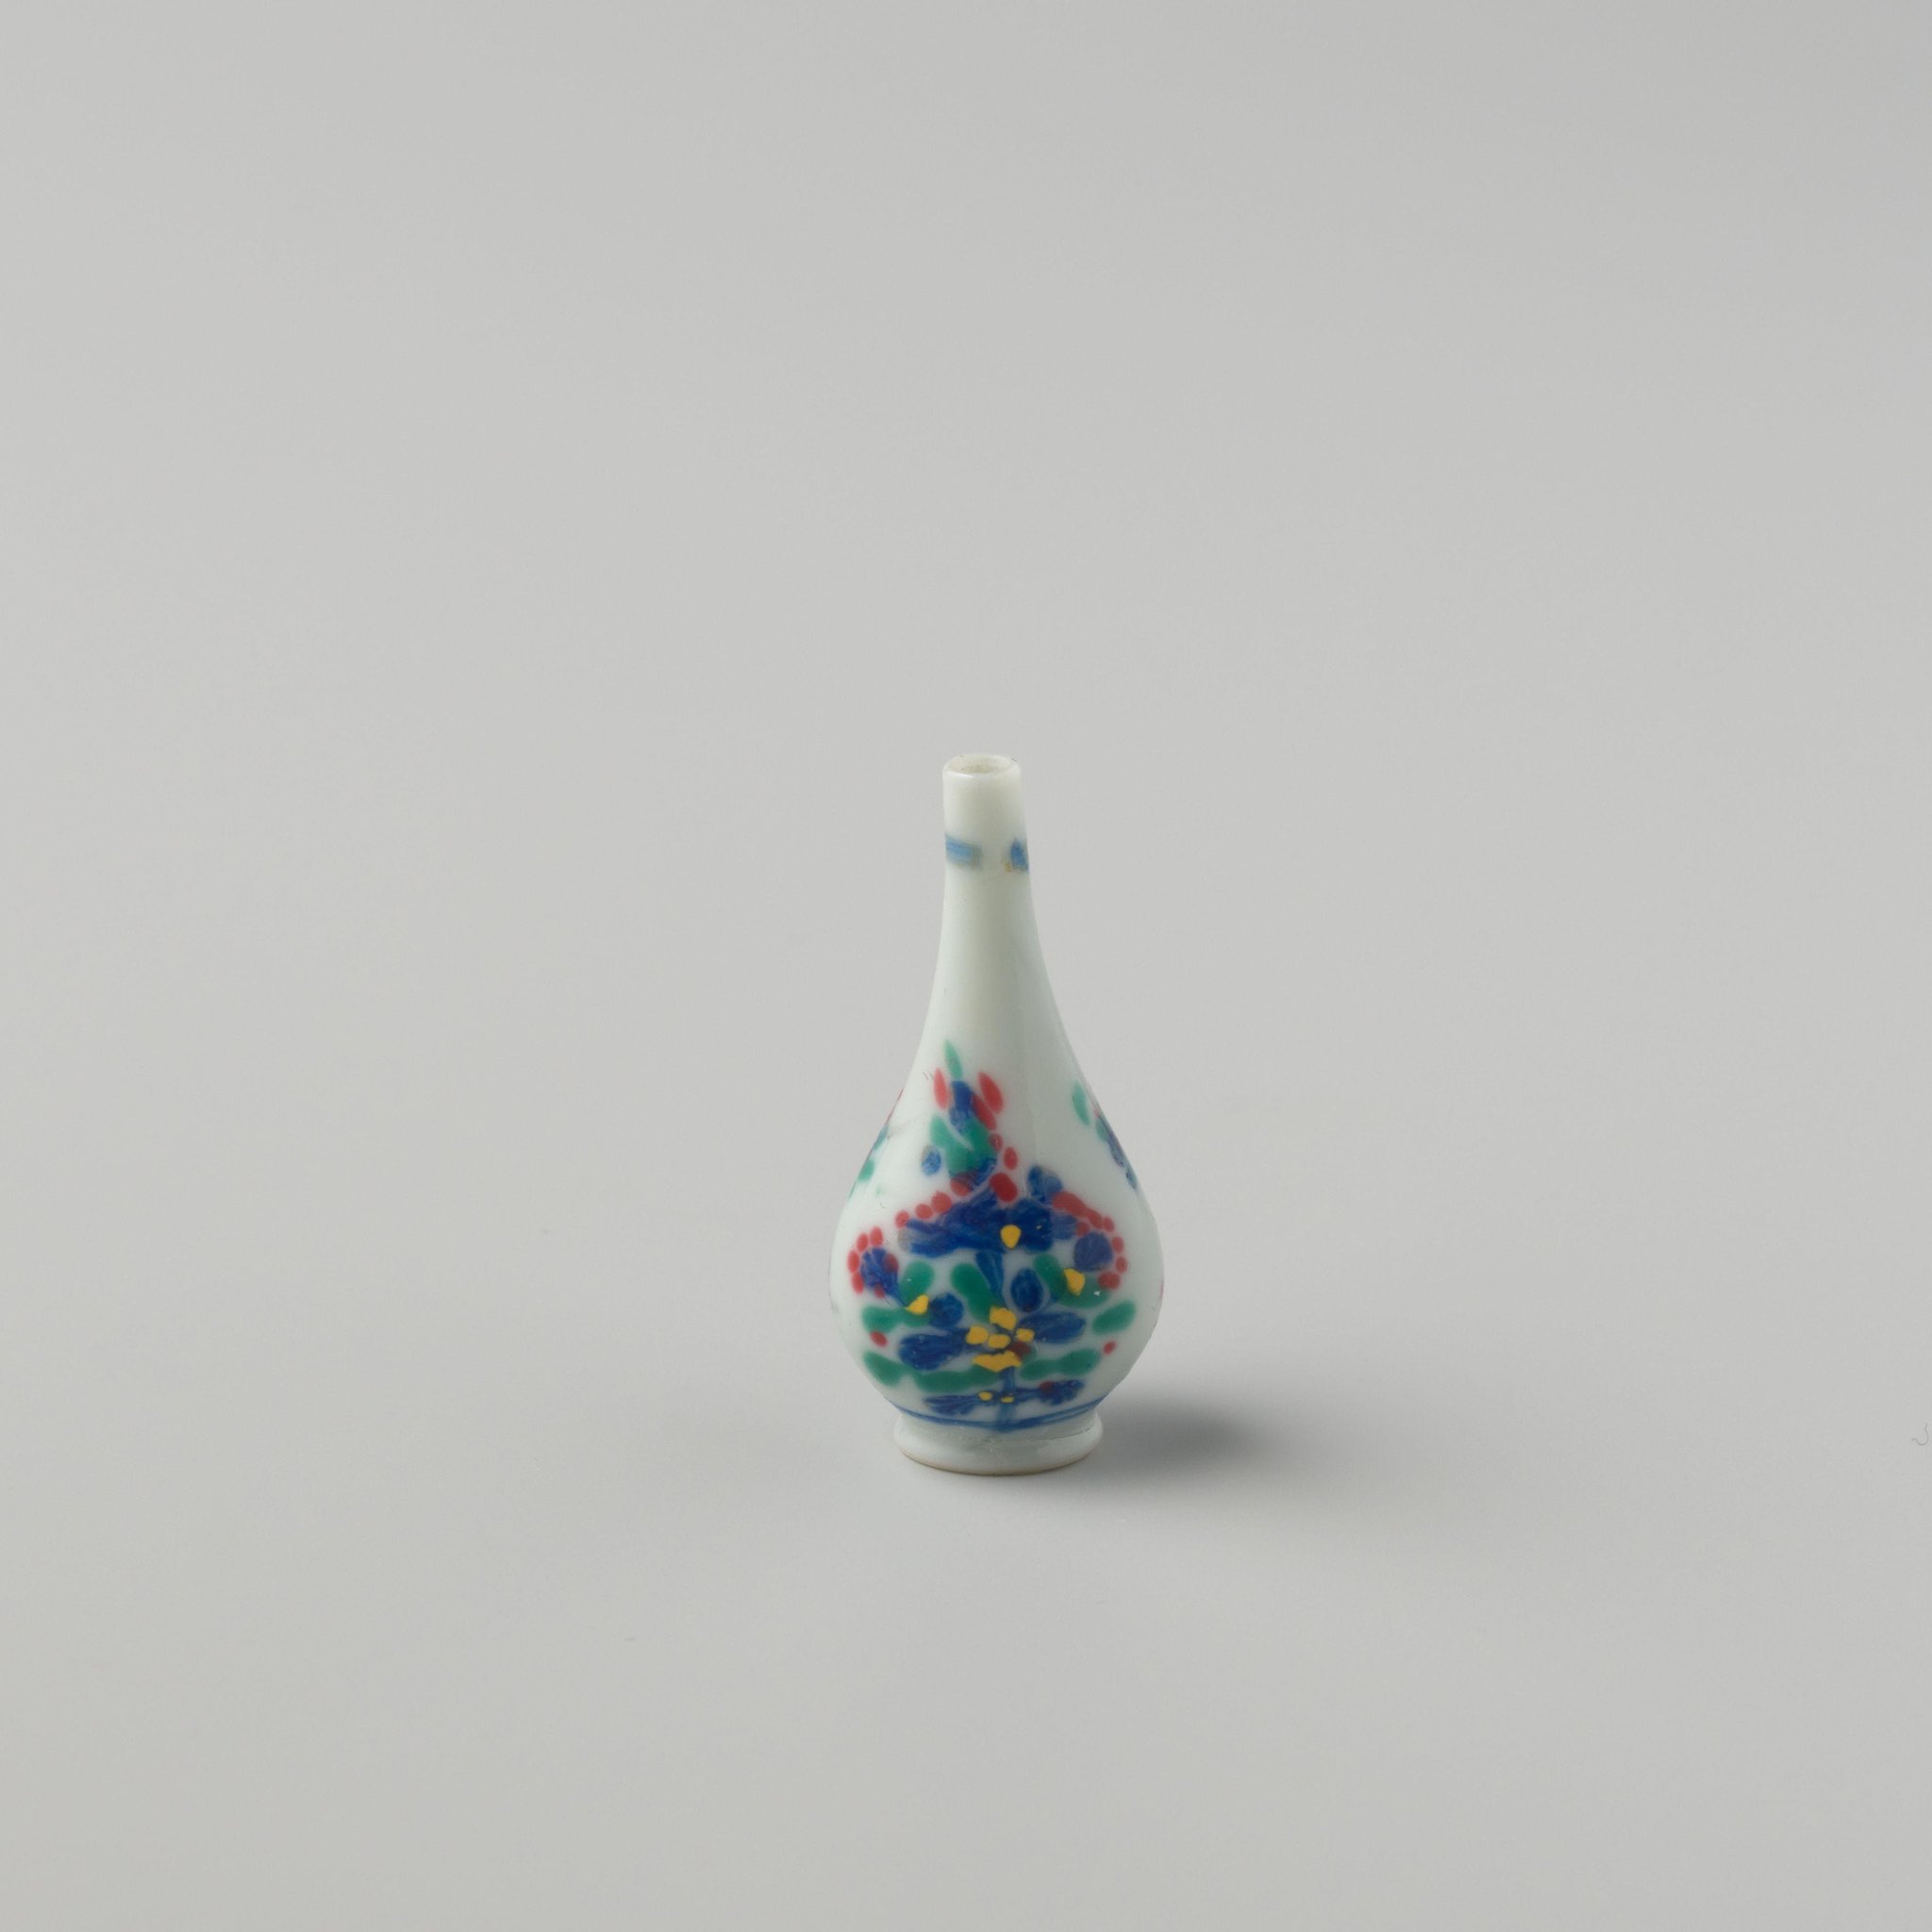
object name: bottle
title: Fles van melkglas met blauwe emailverf beschildering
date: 1675-1700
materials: glass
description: Puntfles van melkglas met veelkleurige emailverf beschildering, imitatie Chinees veelkleurig gedecoreerd porselein; model peervormig op standring, decoratie van twee bloemtuilen in blauw, groen, rood en geel.